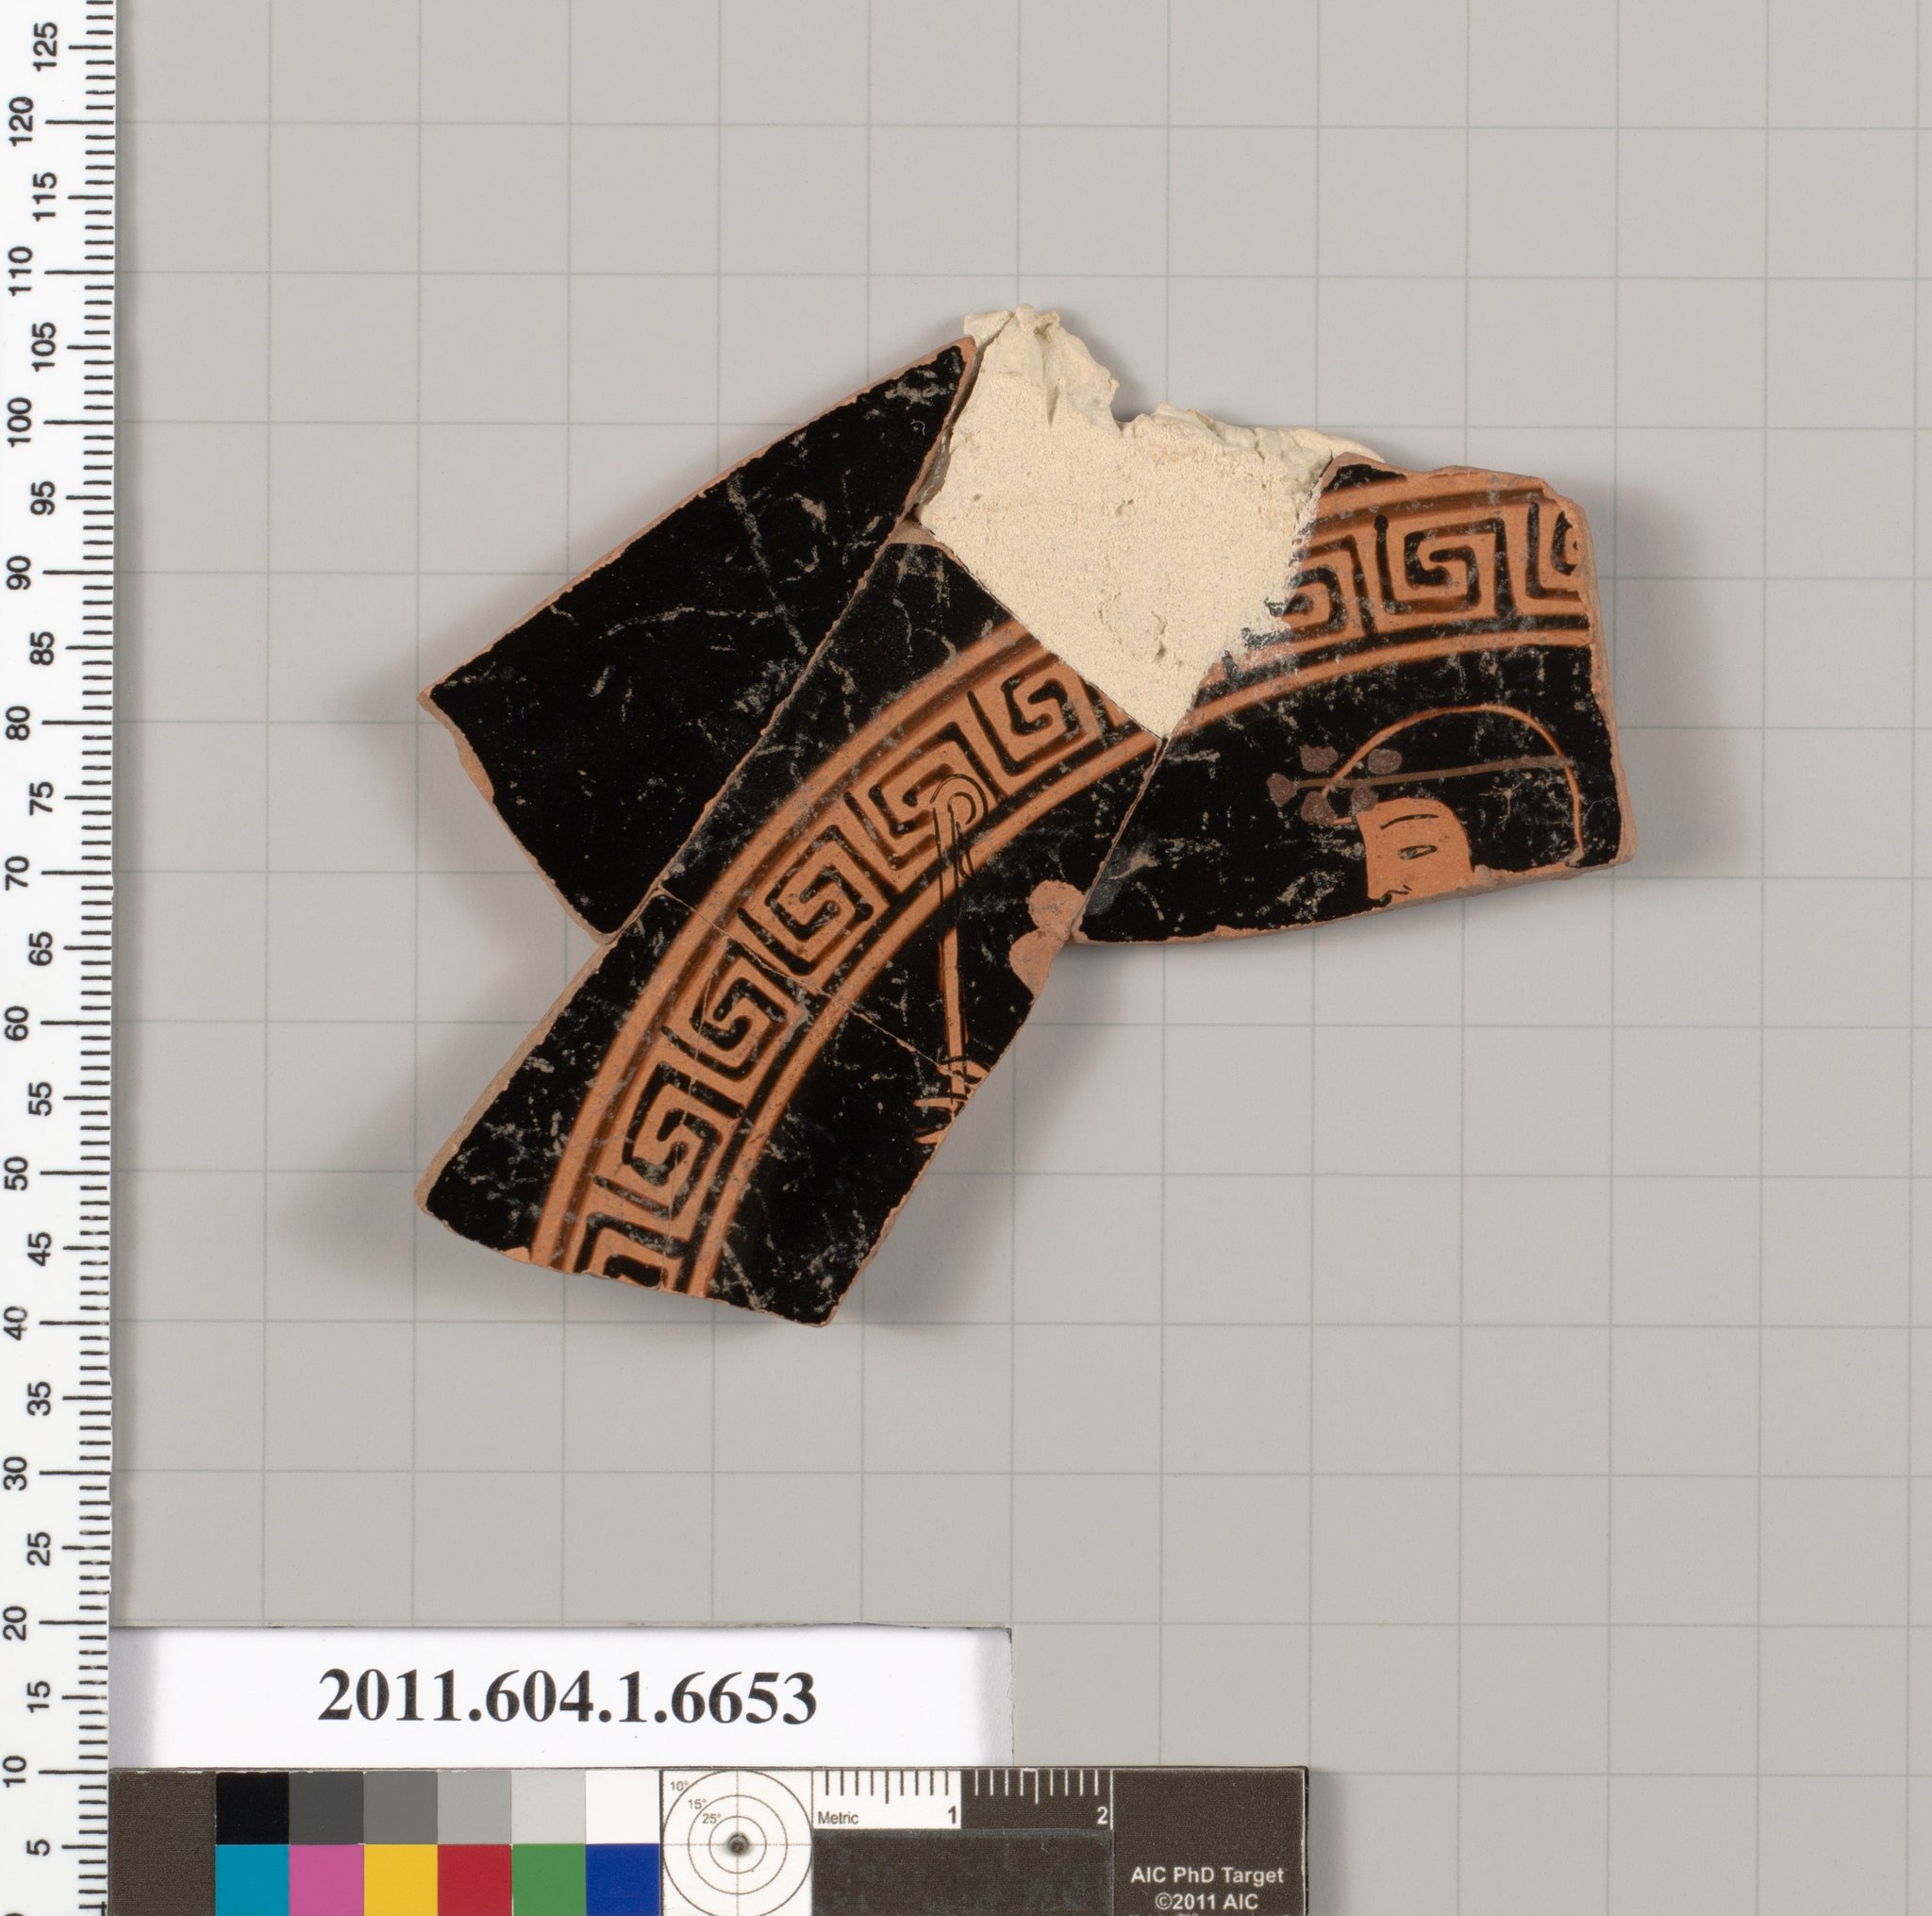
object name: kylix fragment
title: Terracotta fragment of a kylix (drinking cup)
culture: greek, attic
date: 490-470 BCE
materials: terracotta